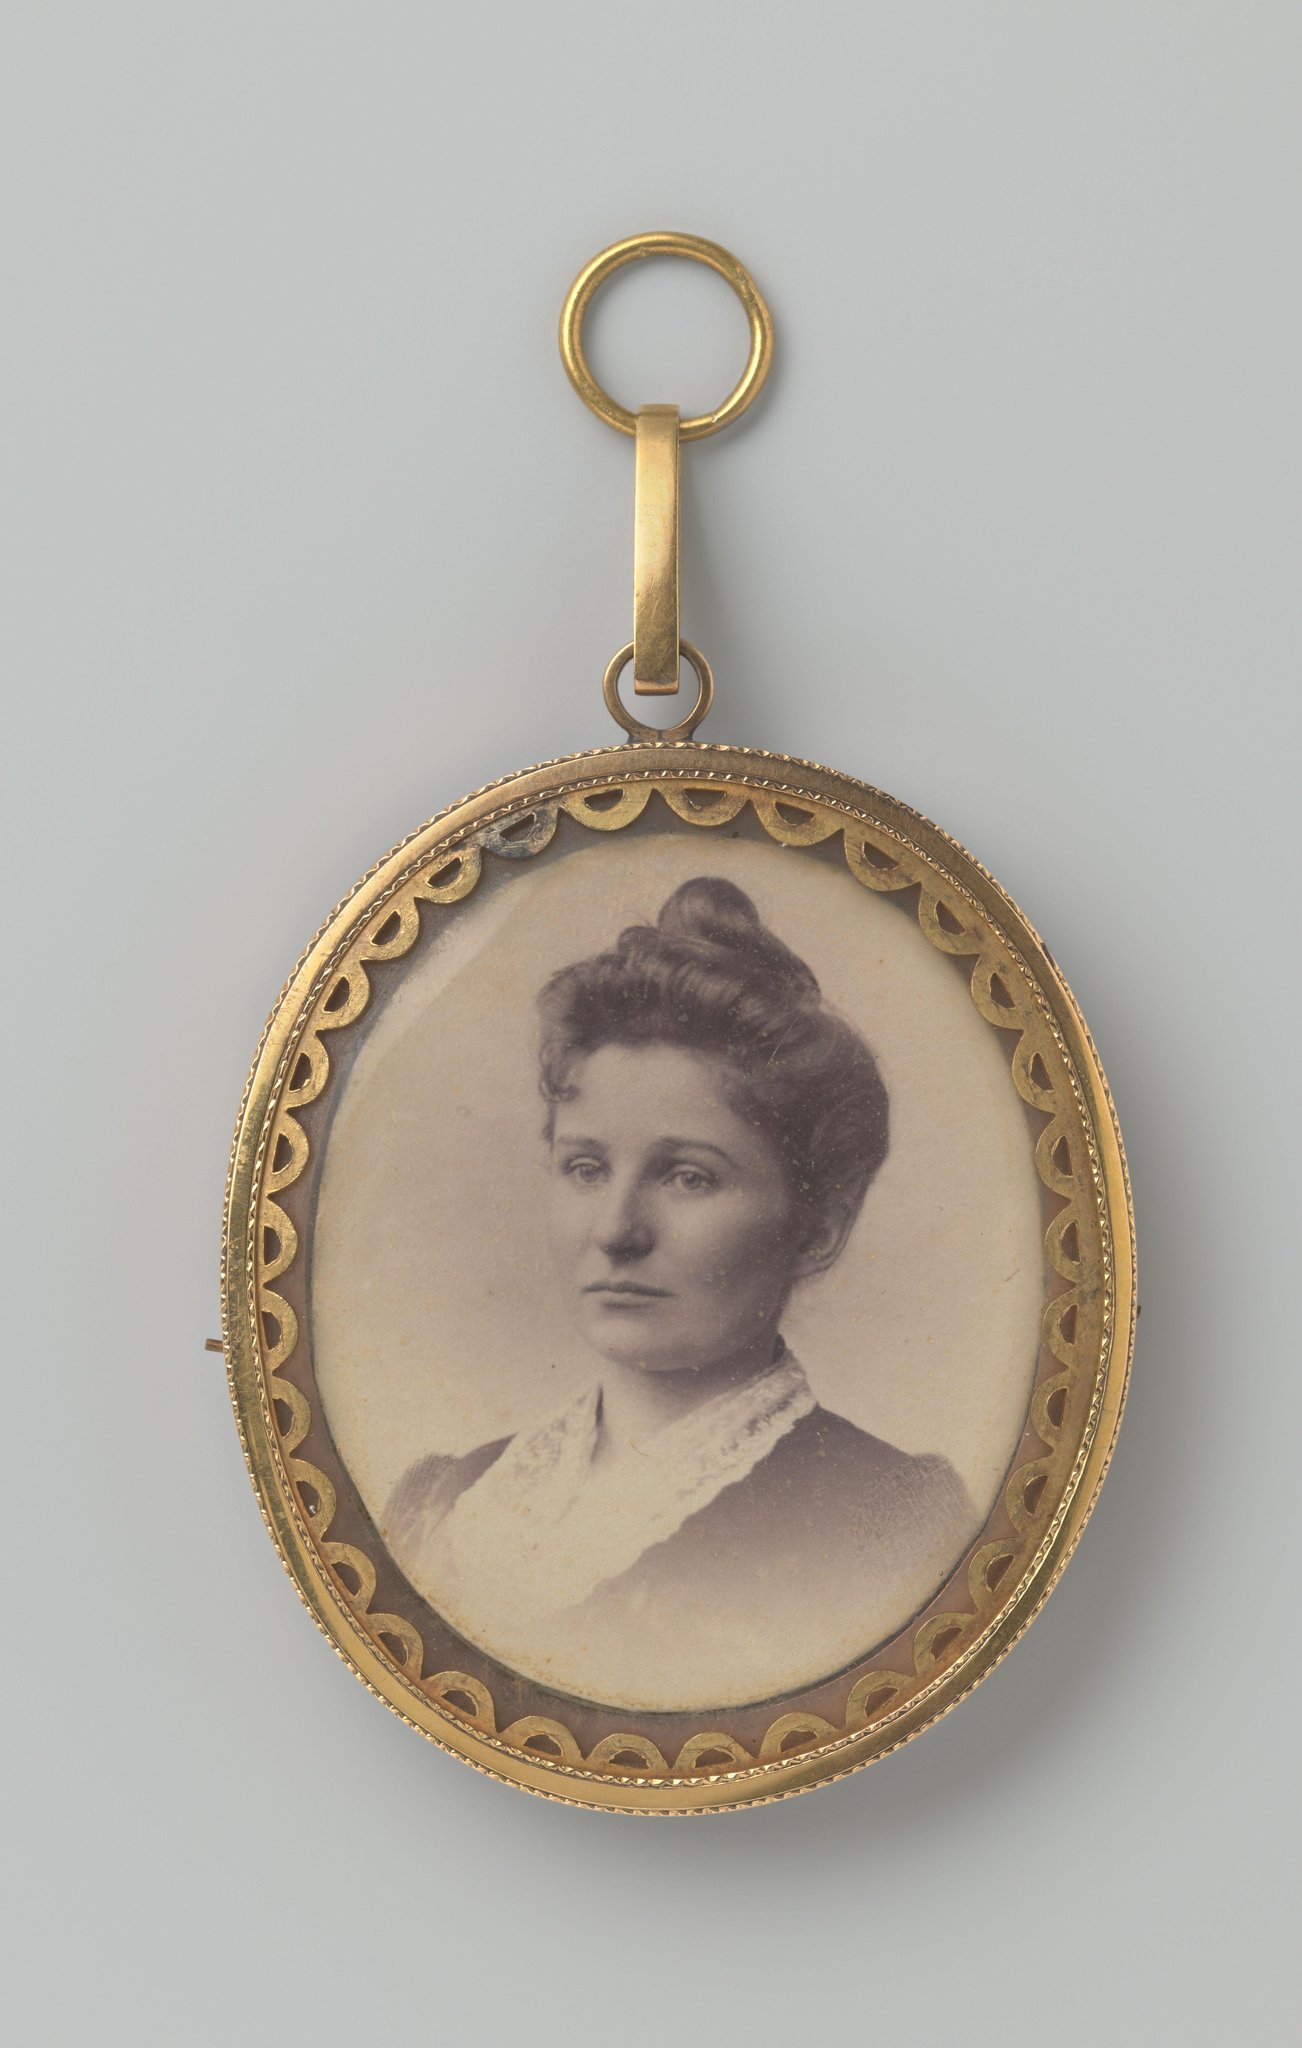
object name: locket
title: Portretmedaillon van verguld koper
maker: Anonymous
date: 1870-1900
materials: copper, gold, hair, ink, paper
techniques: gilding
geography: netherlands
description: Portretmedaillon van verguld koper, ovaal. Op de voorzijde een fotografisch portret: op de achterzijde een allegorie op het huwelijk met altaar en amouretten en het opschrift: AMICIZIA, in twee kleuren inkt op papier en versierd met haarlokken. Met smalle gouden omlijsting.